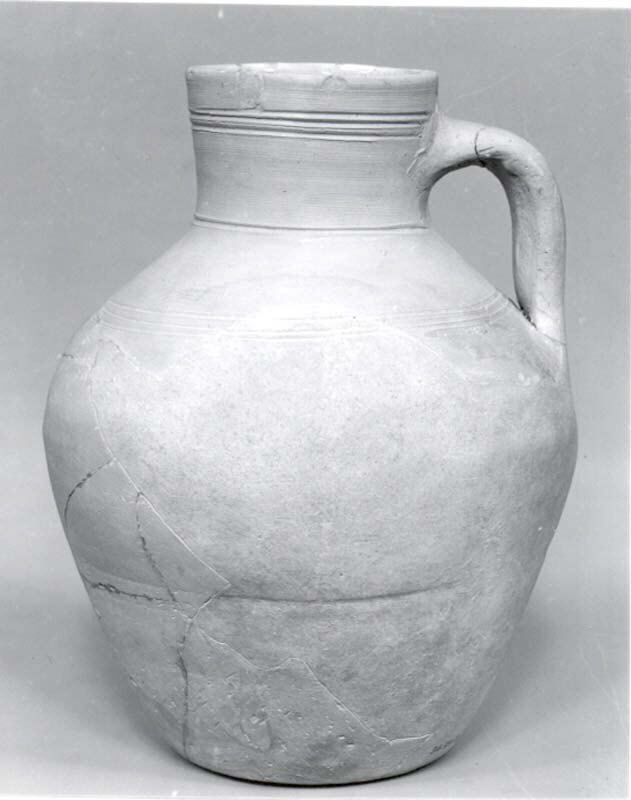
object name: jug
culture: sasanian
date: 201-700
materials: ceramic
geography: iran